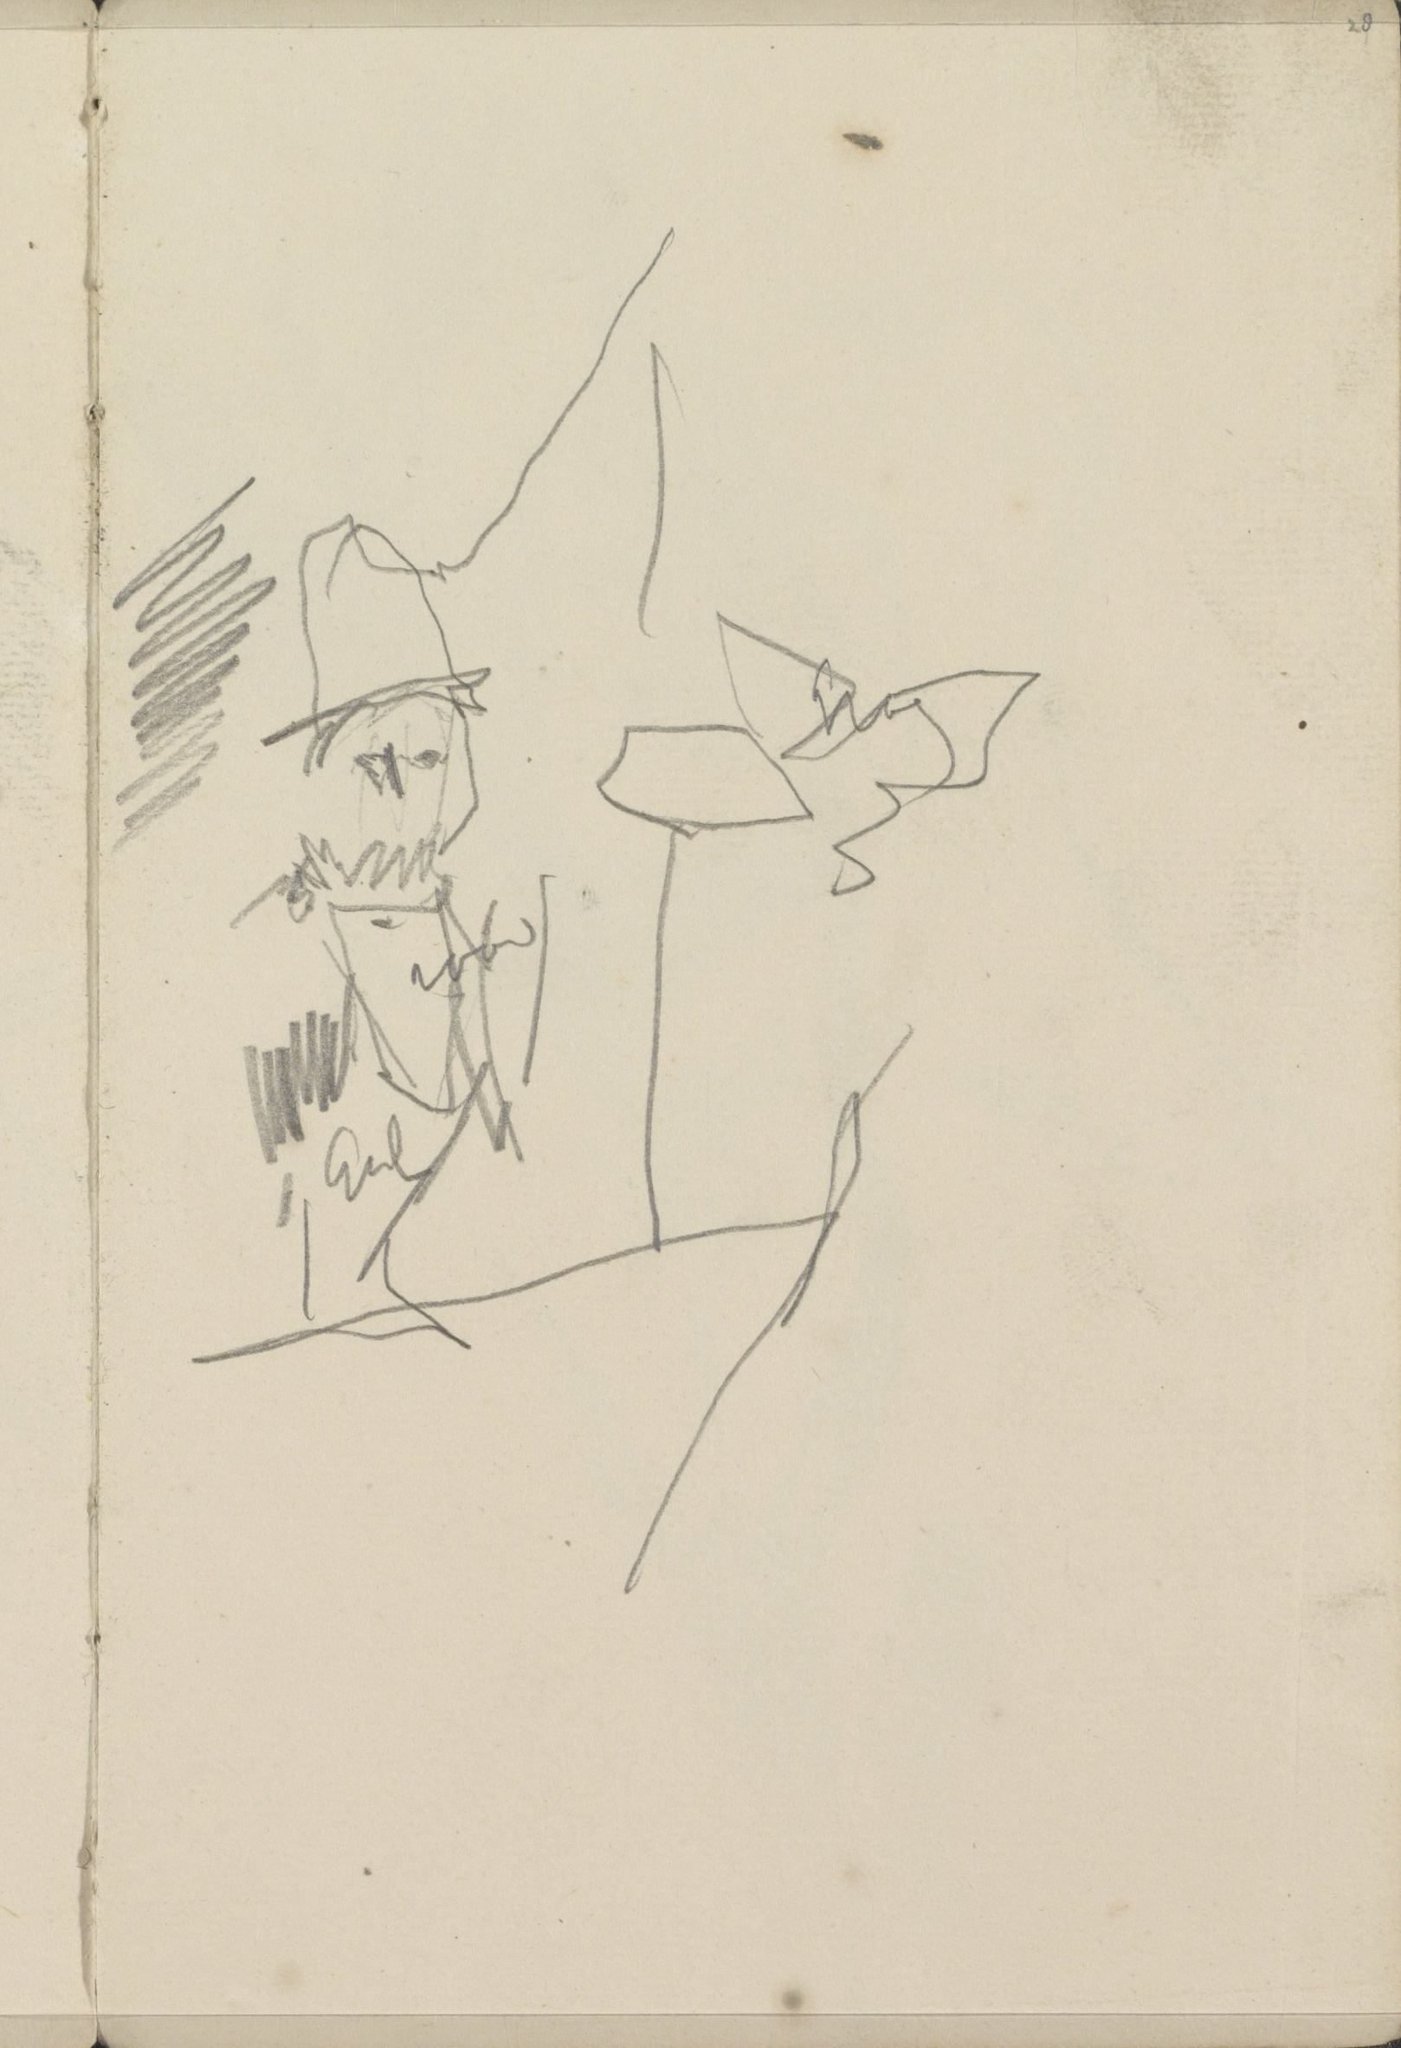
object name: sketchbook leaf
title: Man met hoed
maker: george hendrik breitner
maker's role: draughtsman, painter, print maker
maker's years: 1857-1923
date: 1886-1923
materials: paper, pencil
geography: amsterdam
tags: adult man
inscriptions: kleurnotitie, handgeschreven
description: Pagina 28 uit een schetsboek met 17 bladen.